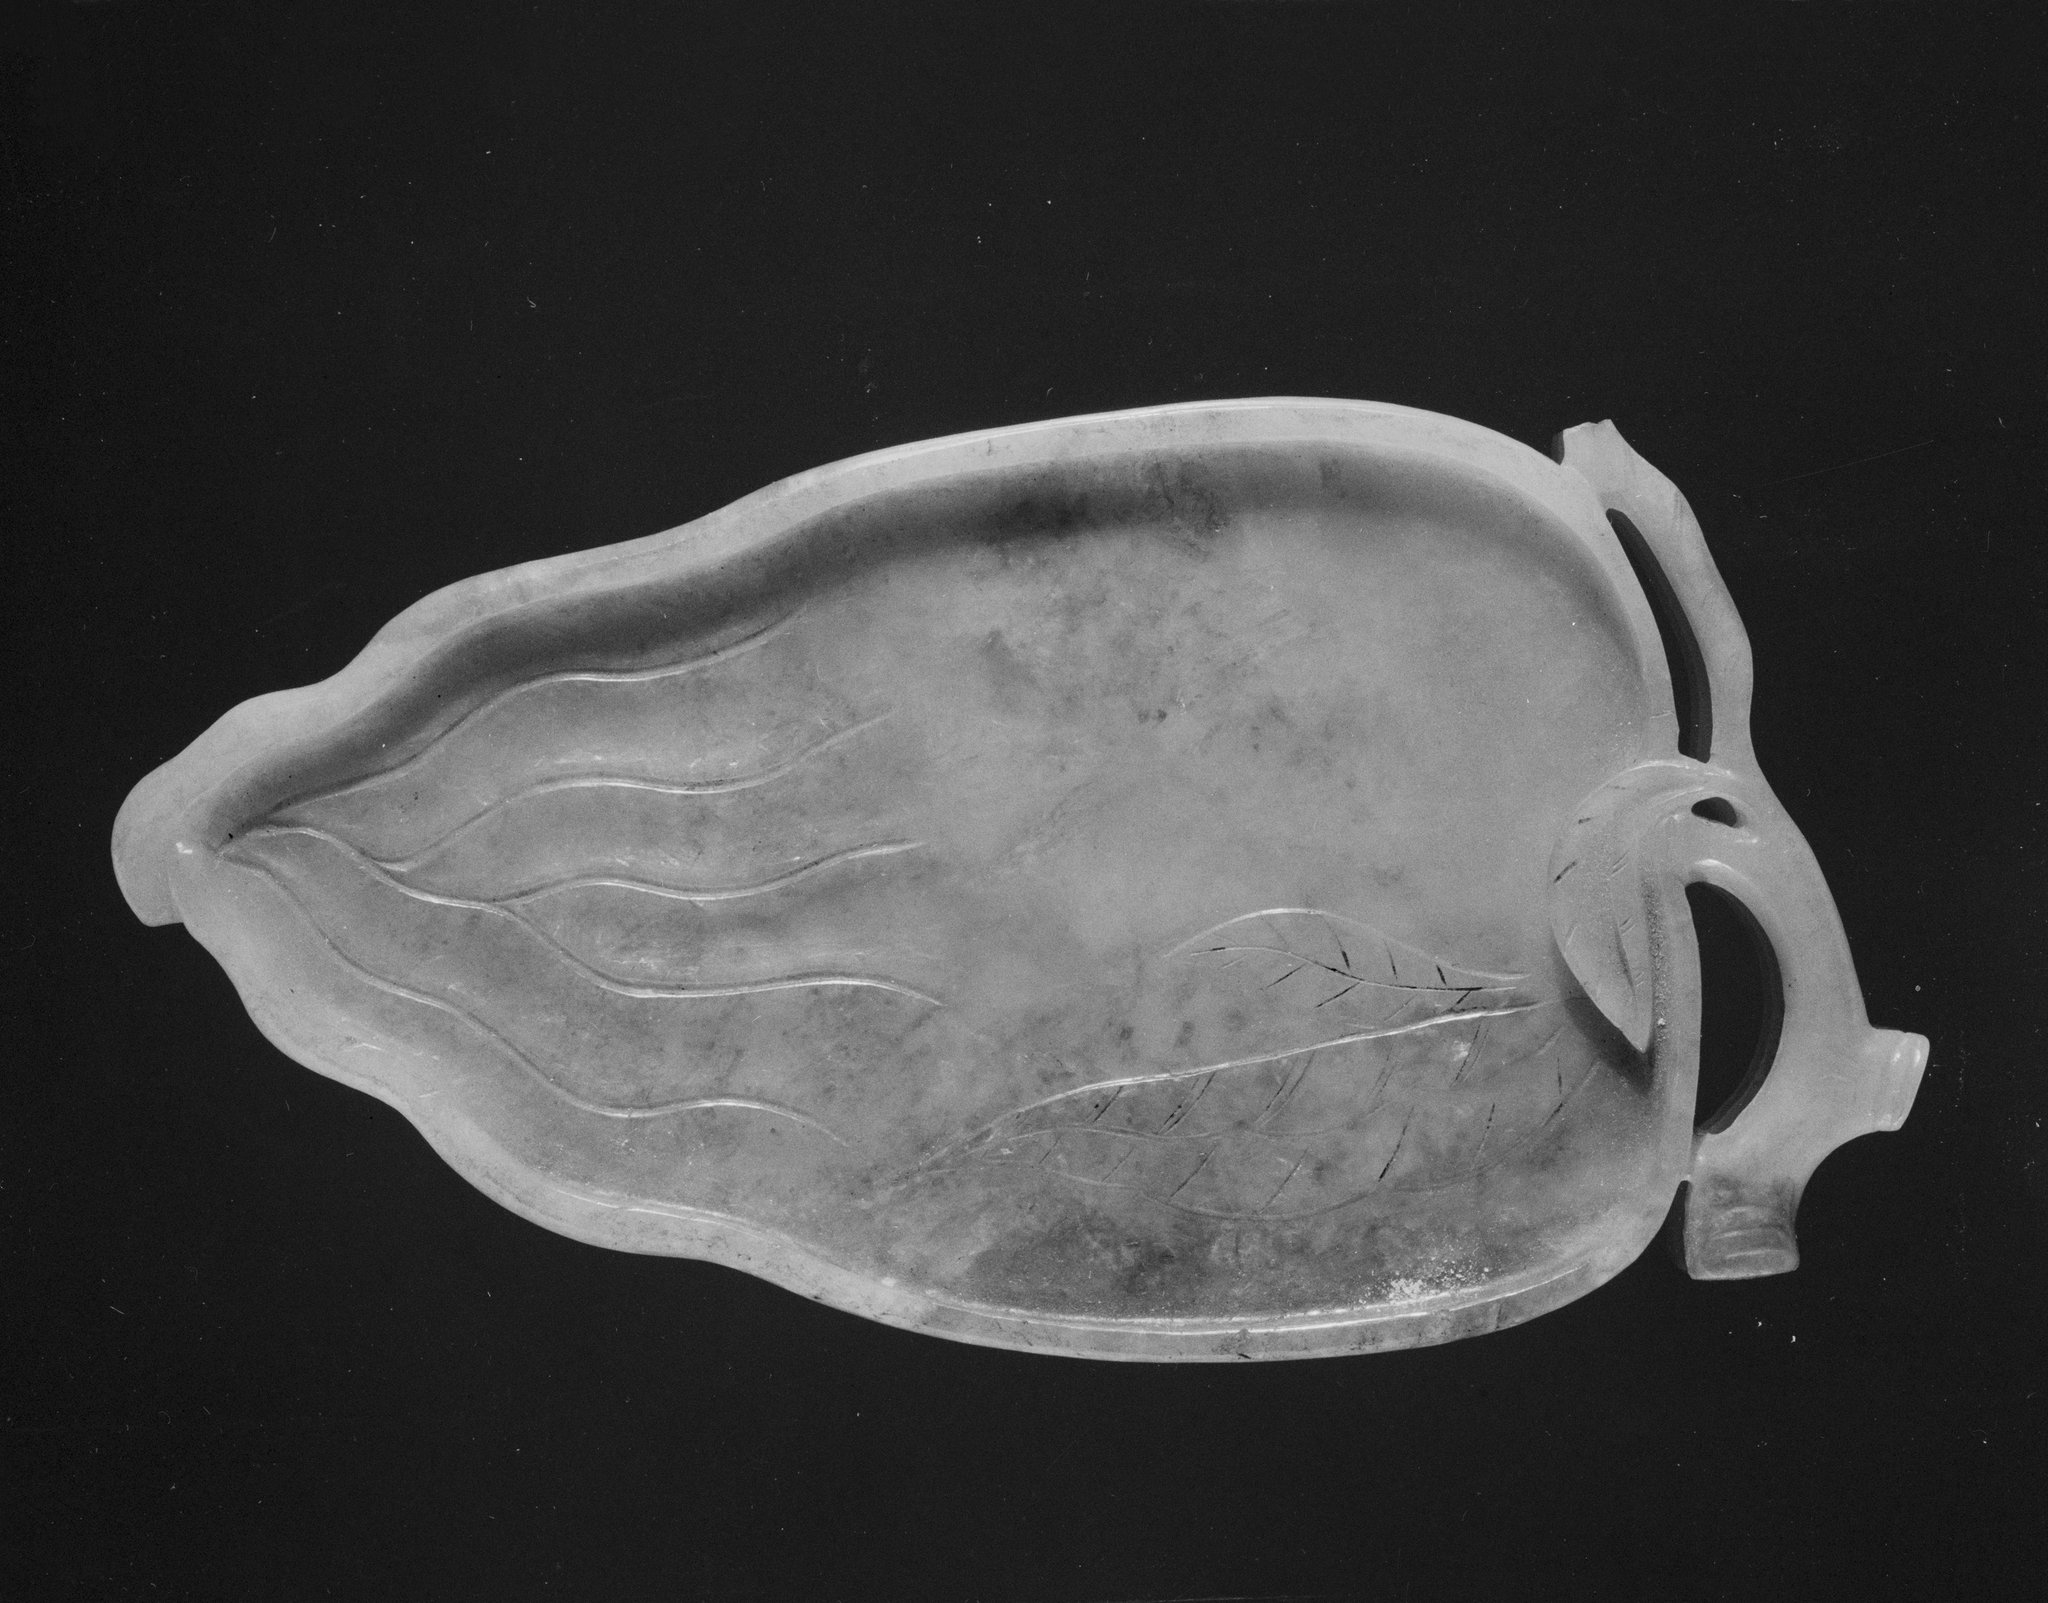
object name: dish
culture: chinese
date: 1644-1911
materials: jade